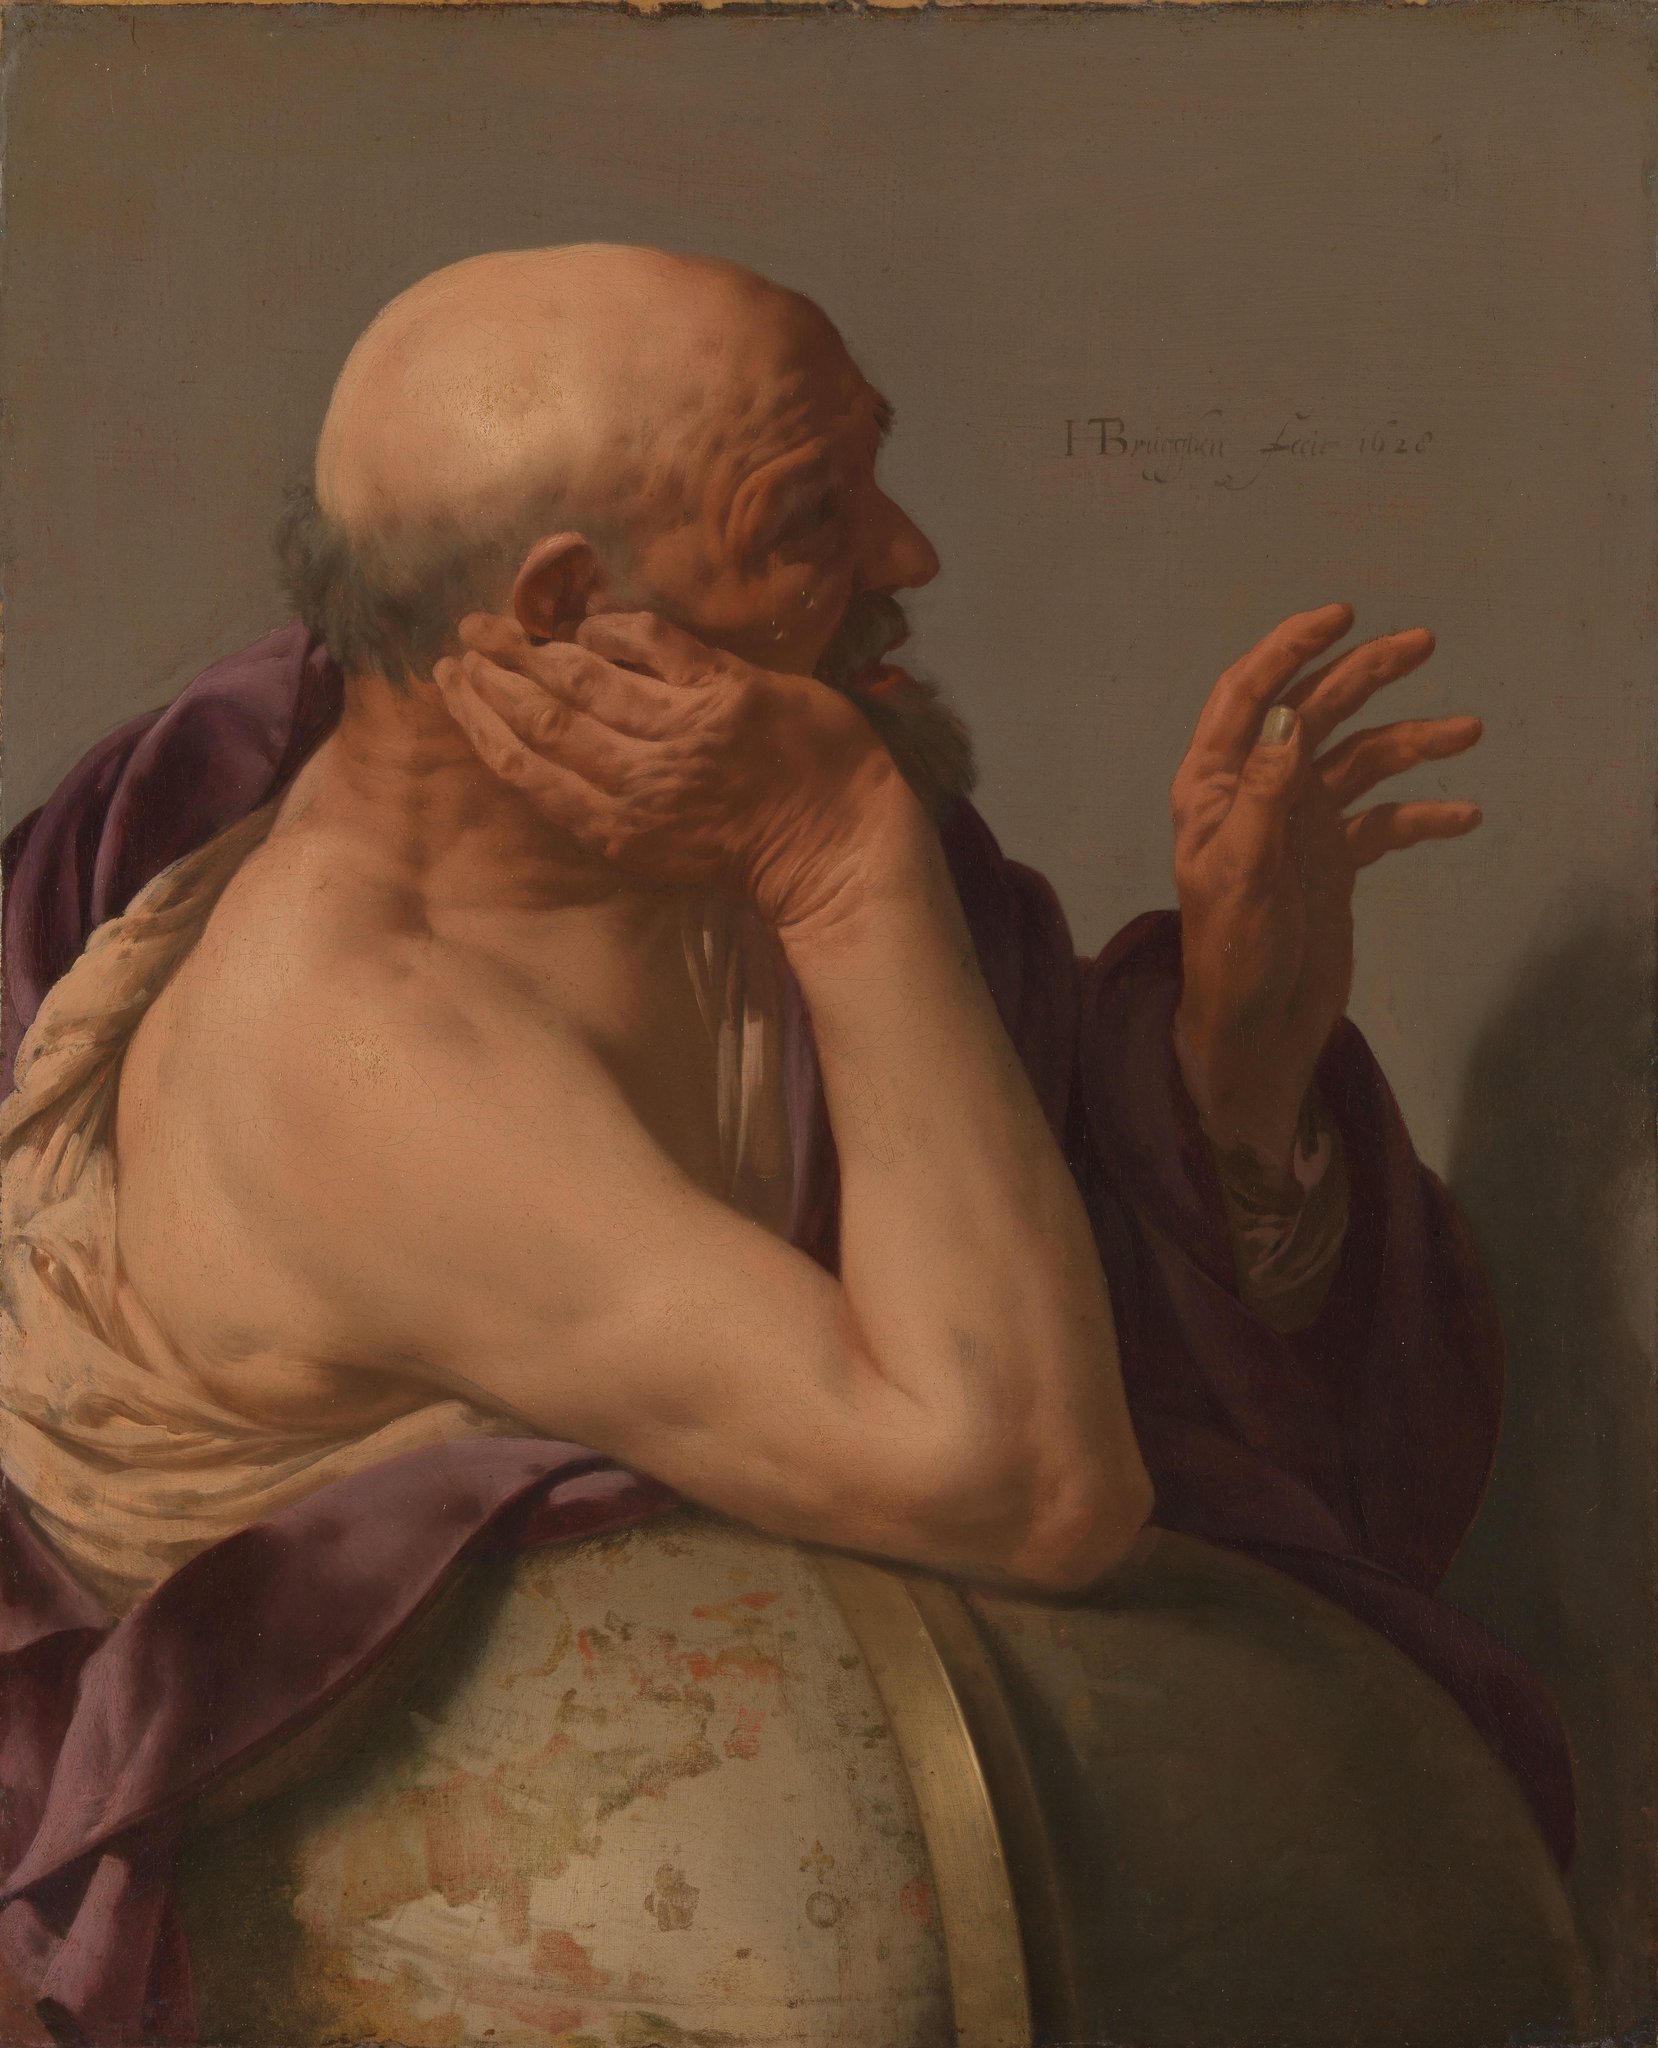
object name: painting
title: Heraclitus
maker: hendrick ter brugghen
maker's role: painter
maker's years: 1588-1629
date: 1628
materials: canvas, oil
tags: globe, heraclitus, the weeping philosopher, and democritus, the laughing philosopher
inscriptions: signature and date, upper right (H, T and B ligated): ‘HTBrugghen fecit 1628’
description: The Greek sage Heraclitus was known as the crying philosopher because he mourned the folly of mankind, while his opposite Democritus (the nearby pendant) could only laugh at it. Here Heraclitus looks like a melancholy old man. Downcast, he leans on a terrestrial globe and gestures dismissively with his left hand, as if to say: ‘All is for nought, the world will come to nothing.’